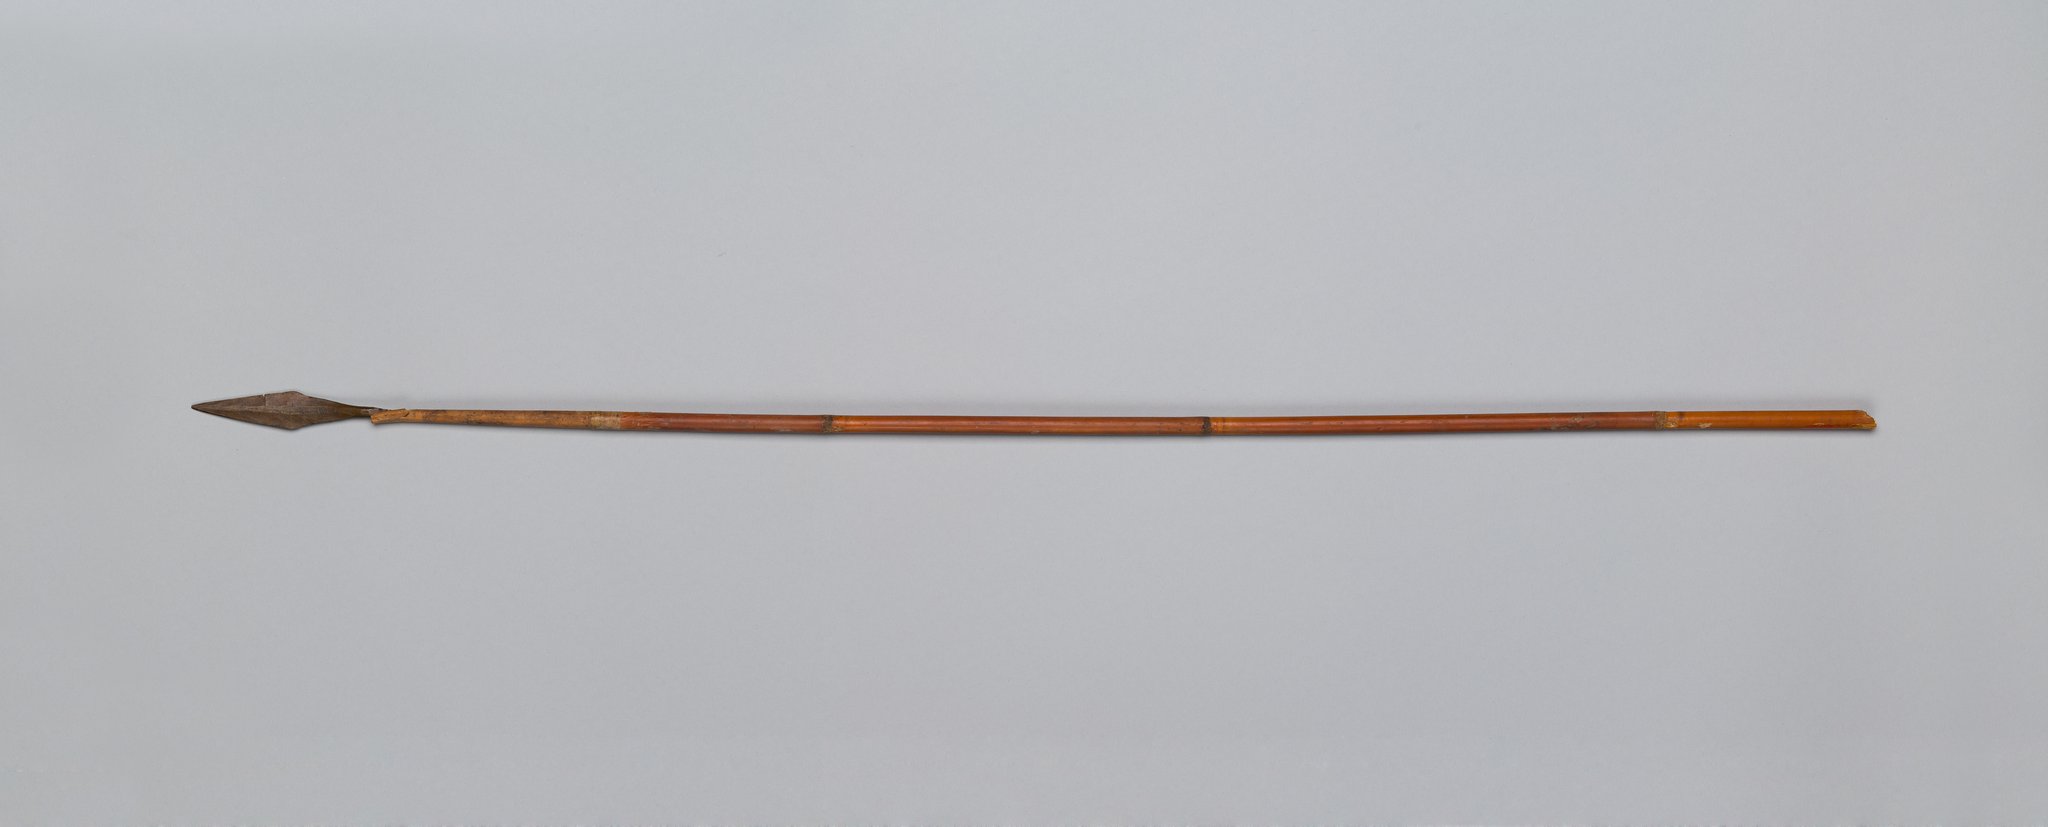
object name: spear, javelin, pointed pile, metal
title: Pointed Pile of a Javelin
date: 1479-1458 BCE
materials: bronze, copper alloy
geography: egypt